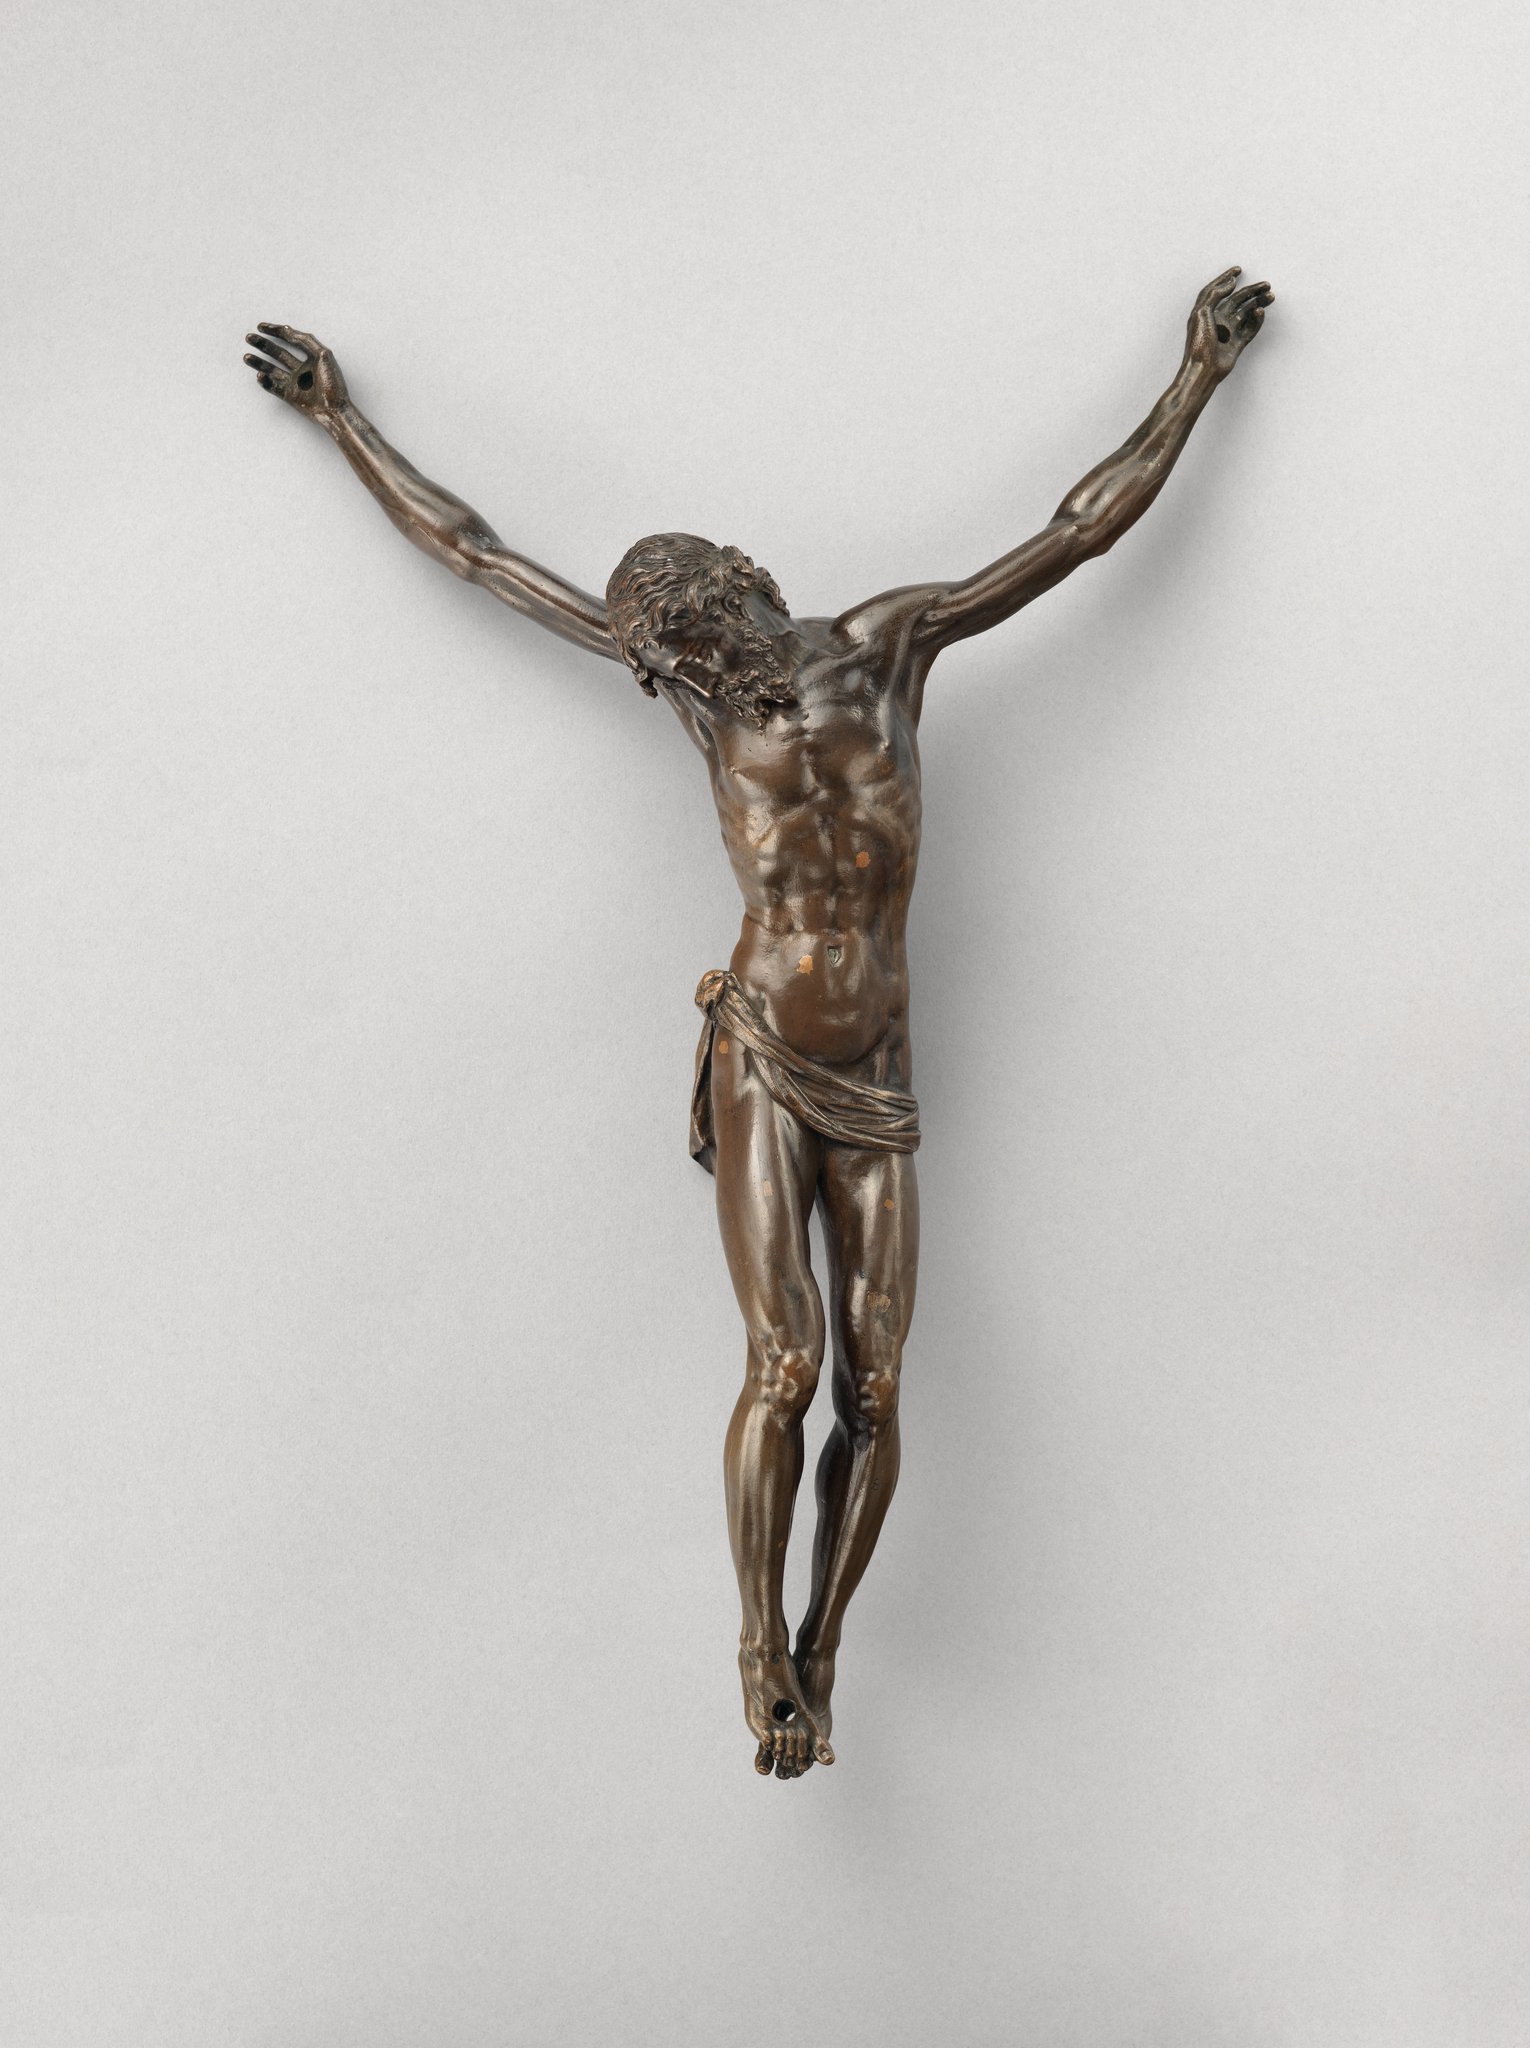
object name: corpus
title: The crucified Christ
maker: antonio susini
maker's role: artist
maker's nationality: italian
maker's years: 1558-1624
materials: bronze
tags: christ,cross,jesus,crucifixion